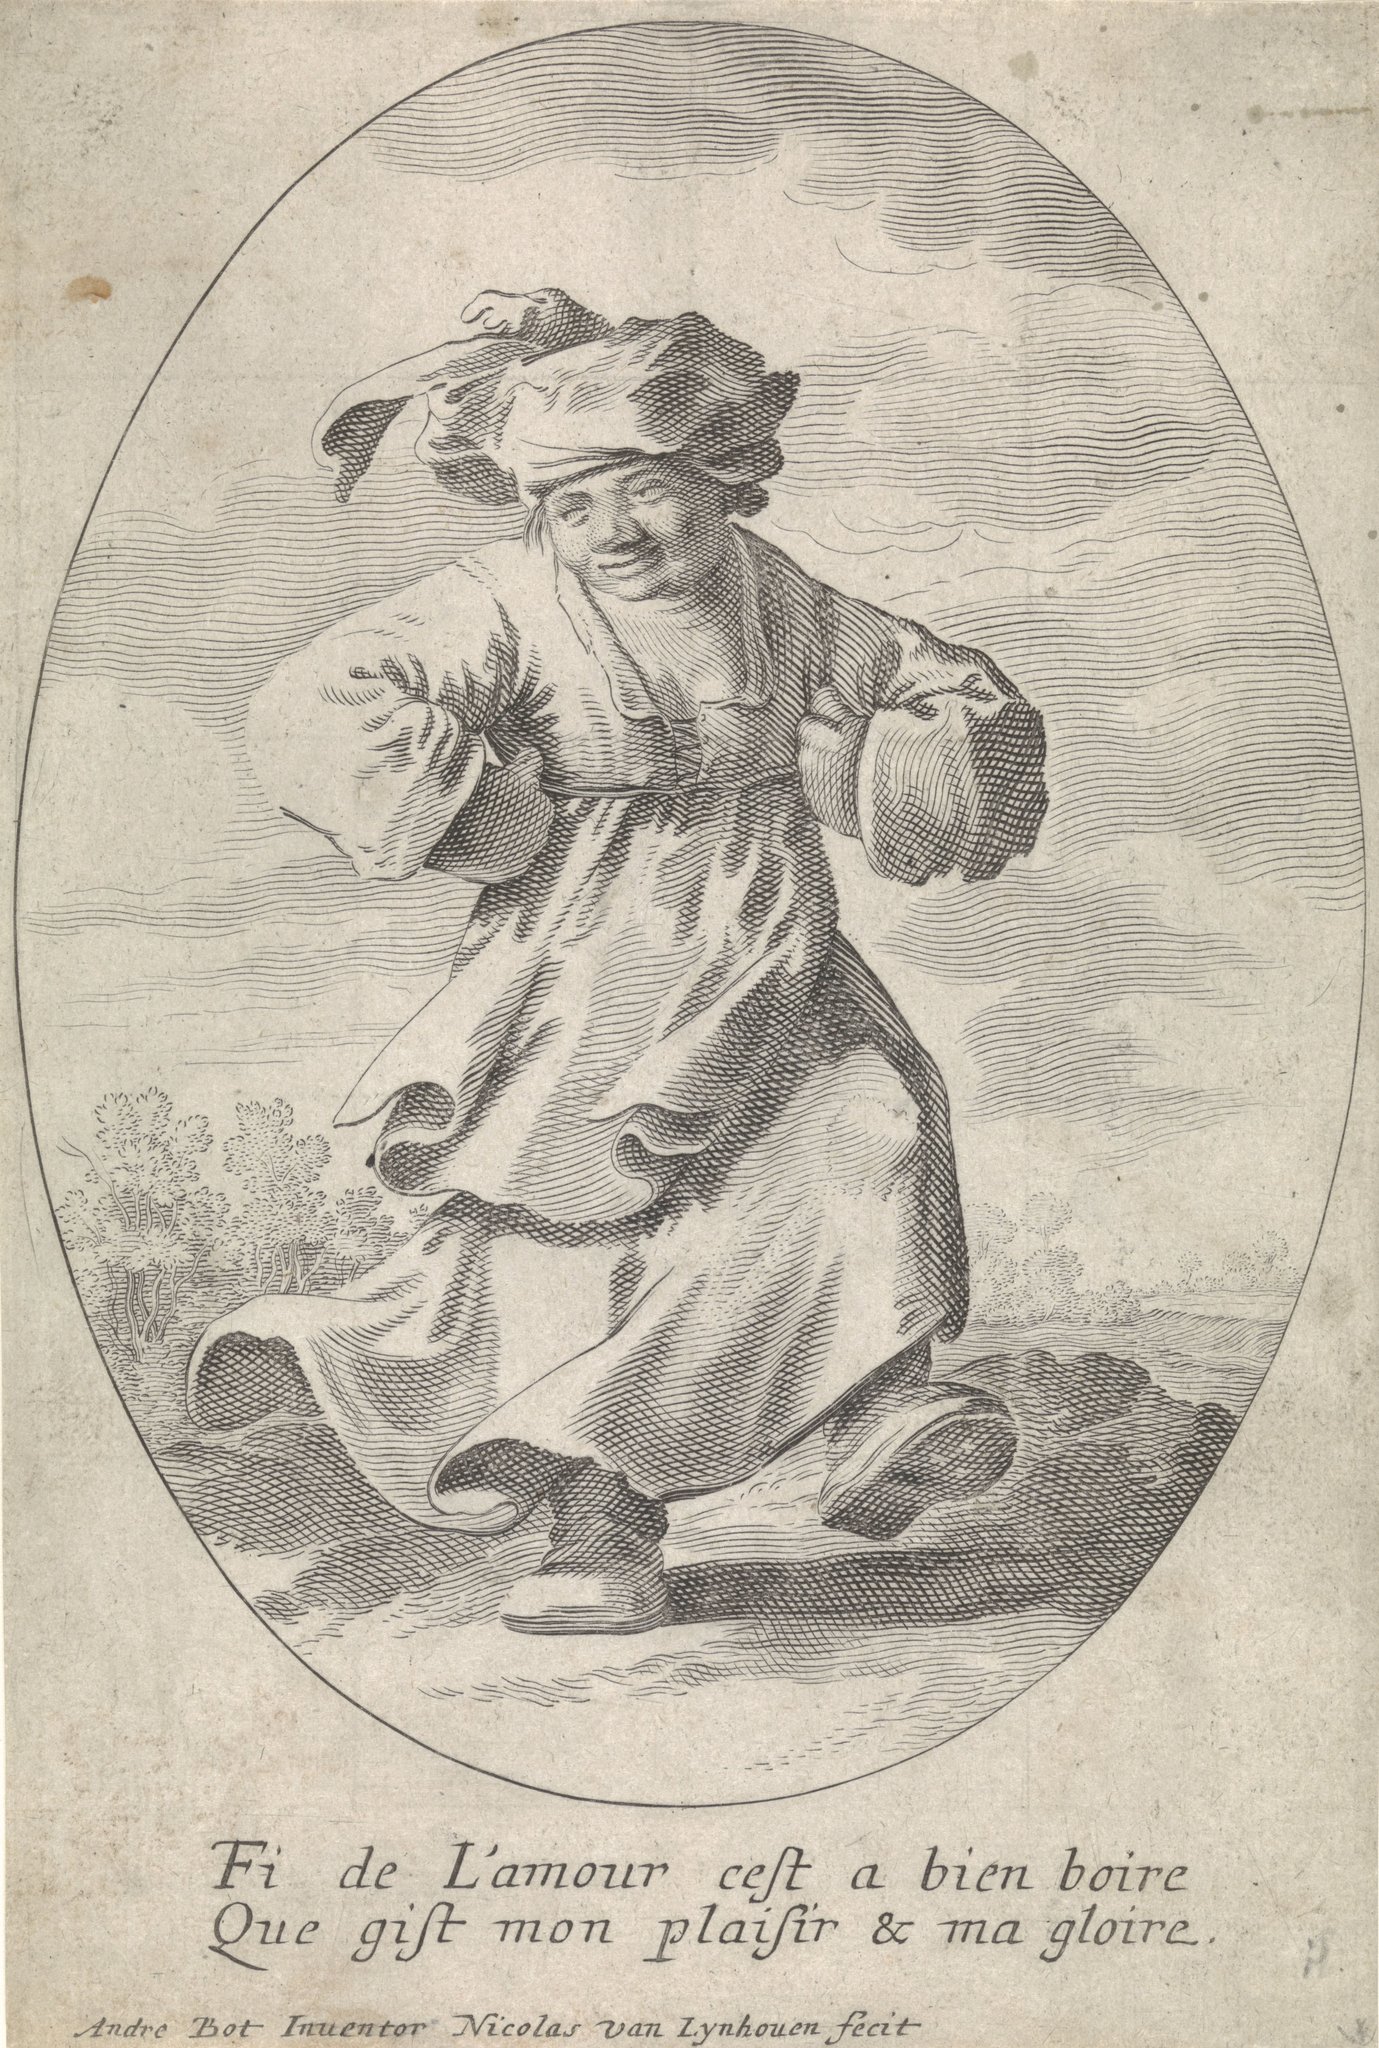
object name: print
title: Dansende boerin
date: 1622-1668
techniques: engraving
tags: scabrous scenes, pornography (+ variant), gesture-language, farmers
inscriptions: collector's mark: Lugt 2228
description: Een dansende boerin in een landschap, met de handen in de zij. Onder de ovale voorstelling een tweeregelig Frans vers.